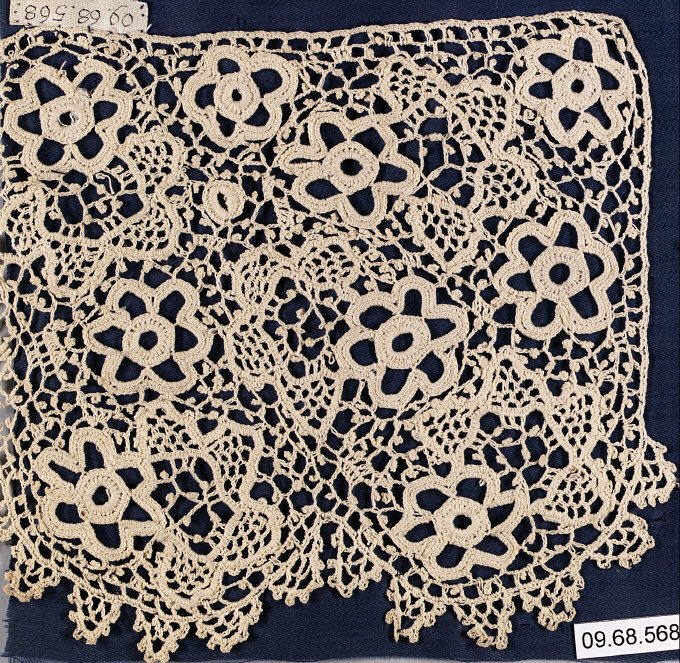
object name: specimen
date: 1801-1900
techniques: crochet